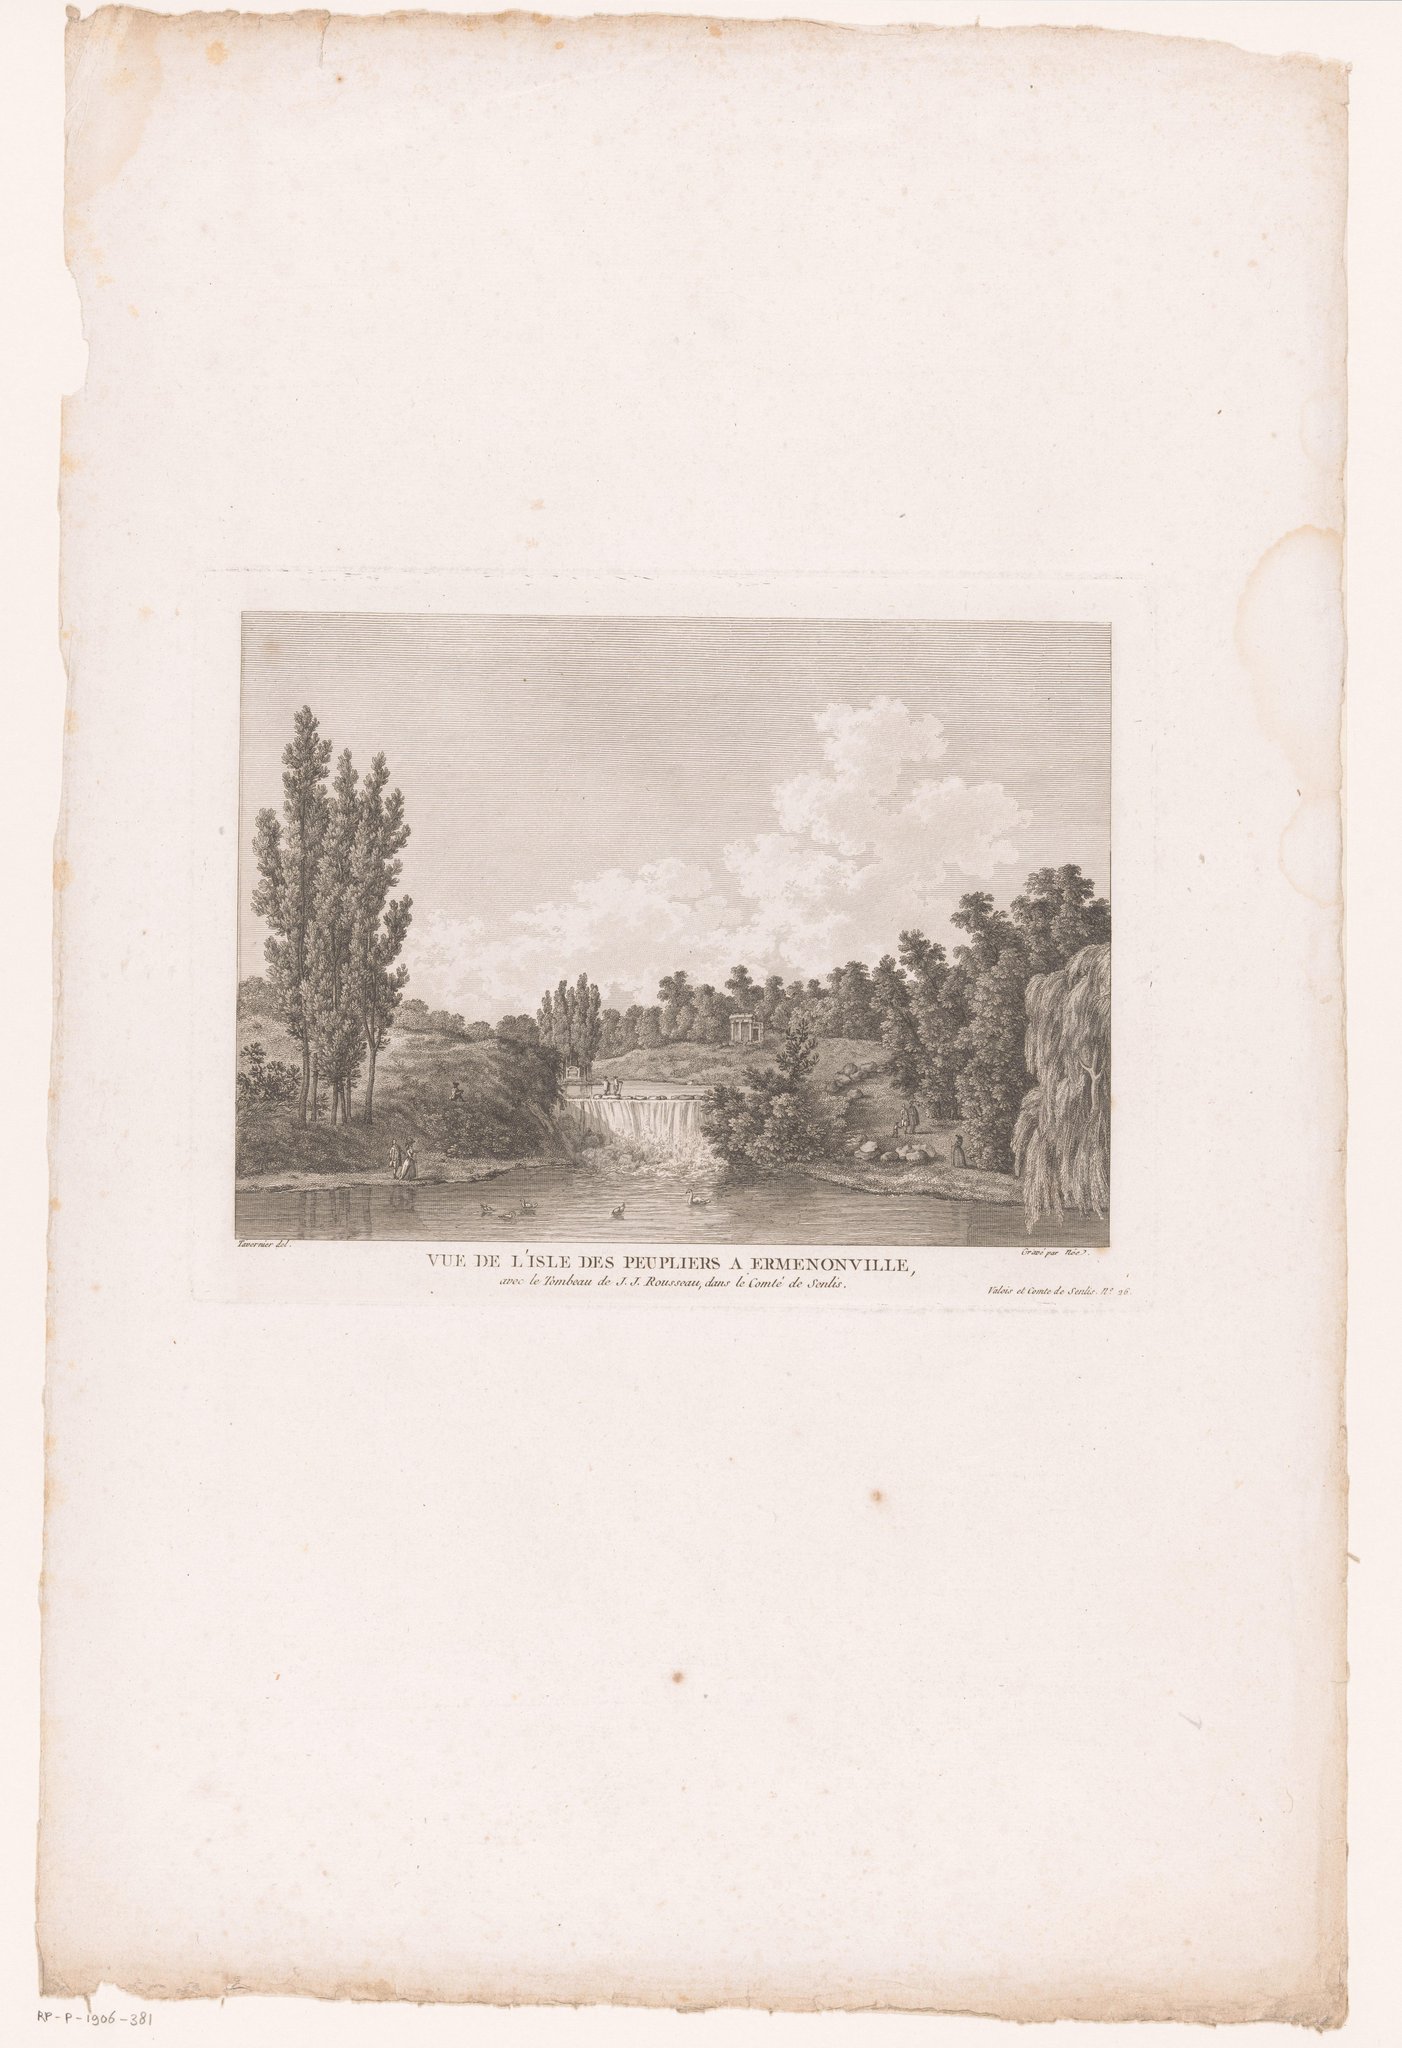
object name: print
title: Gezicht op het Île des Peupliers te Ermenoville met de tombe van Jean-Jacques Rousseau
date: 1778-1817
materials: paper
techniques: etching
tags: waterfall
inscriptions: collector's mark: Lugt 2228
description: Genummerd rechtsonder: Valois et Comte de Senlis. No. 26.